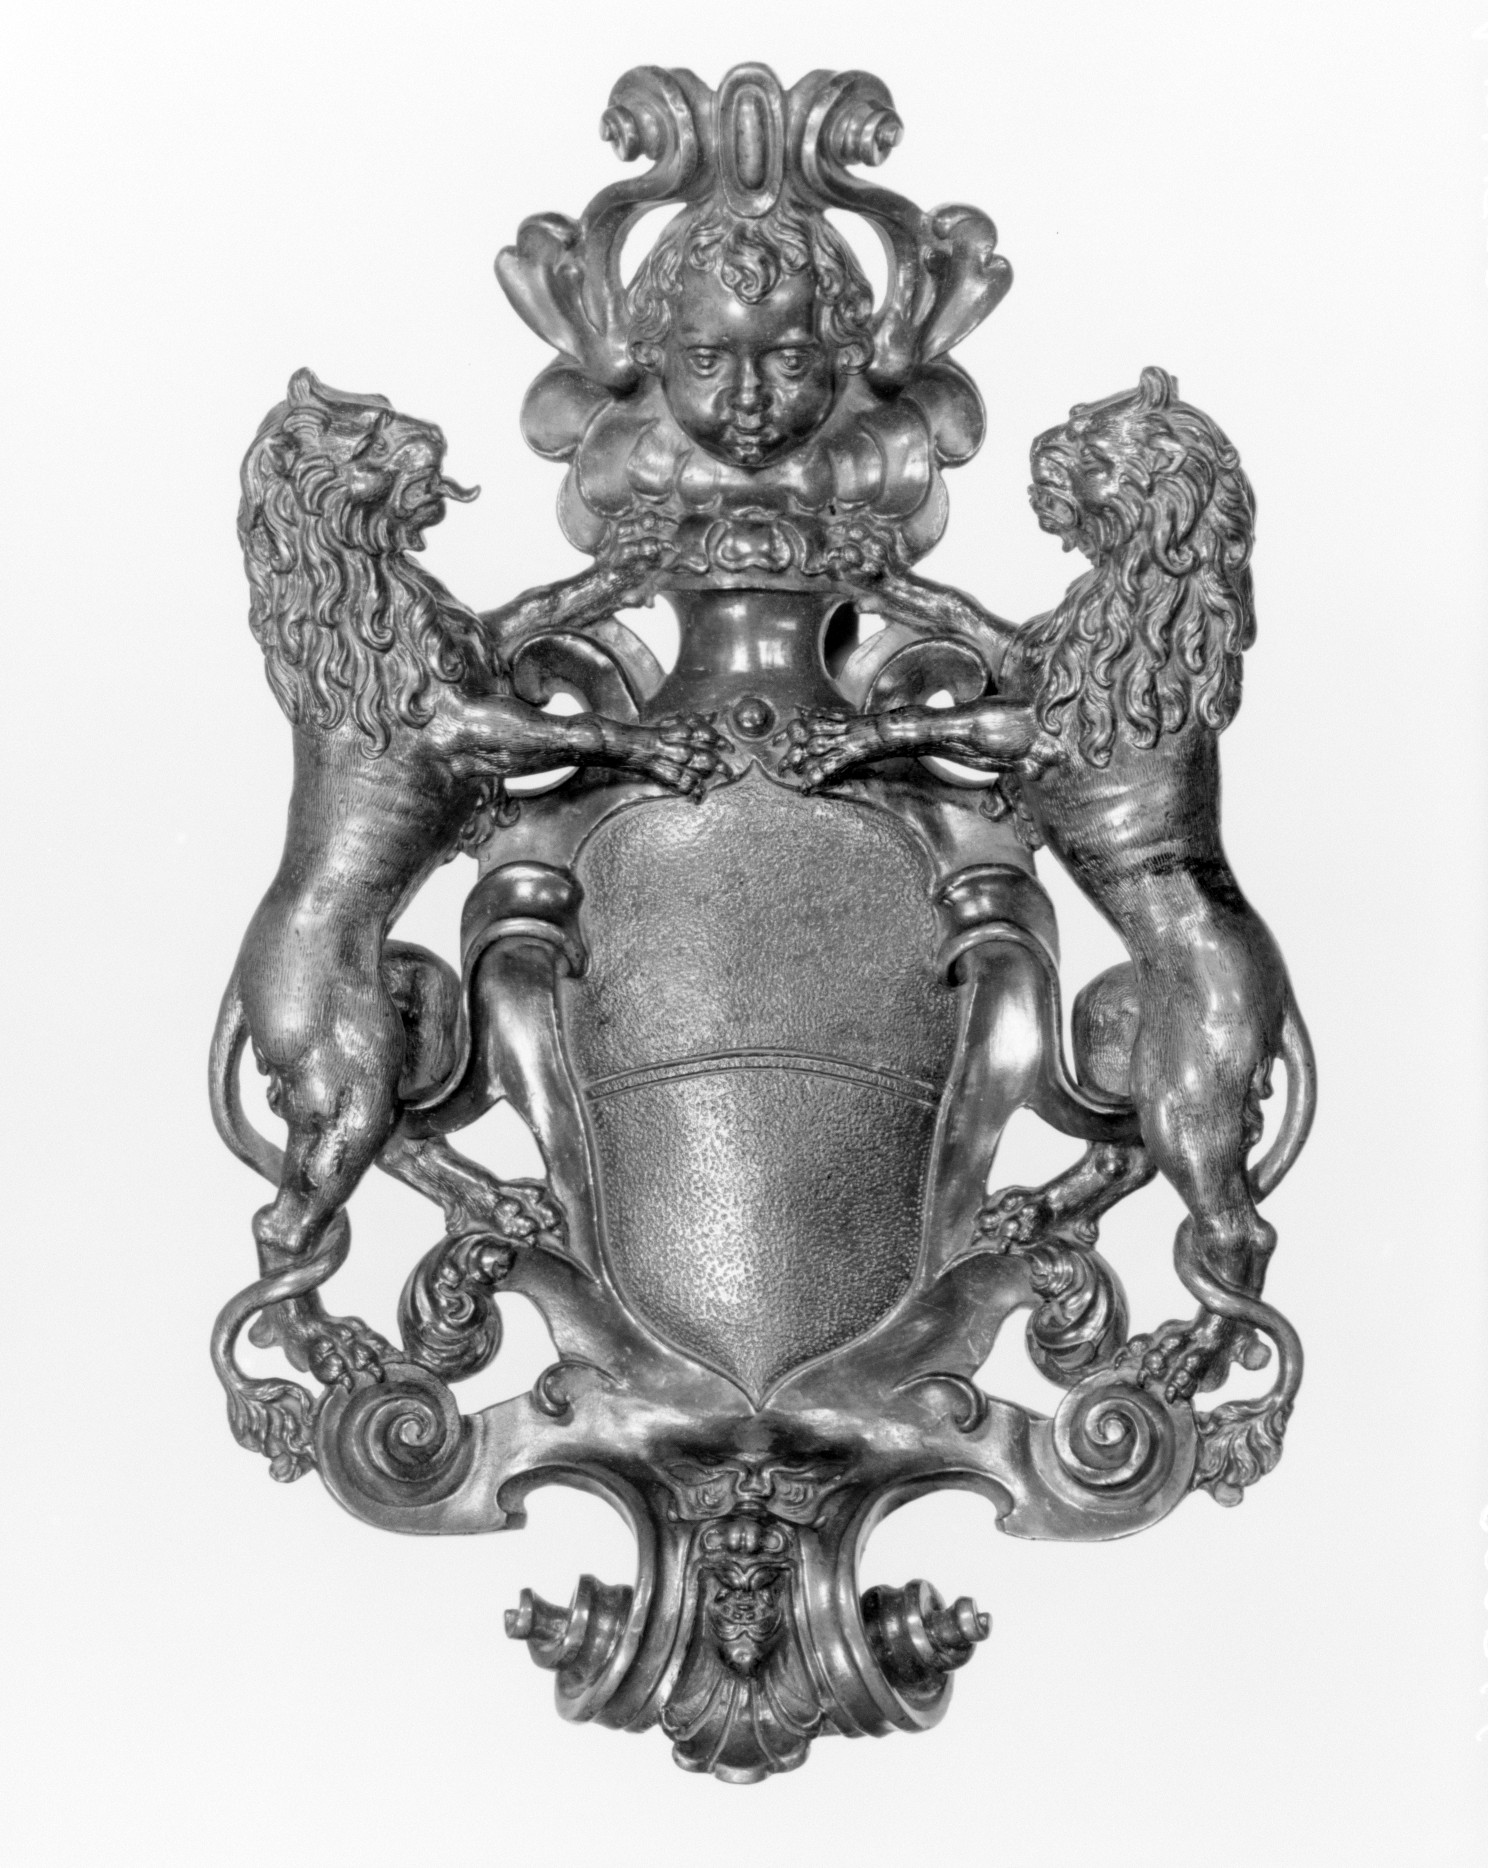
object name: door knocker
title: Door knocker (one of a pair)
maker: hubert gerhard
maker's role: artist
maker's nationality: netherlandish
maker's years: 1540-1621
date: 1600-1625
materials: bronze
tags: faces,lions,coat of arms